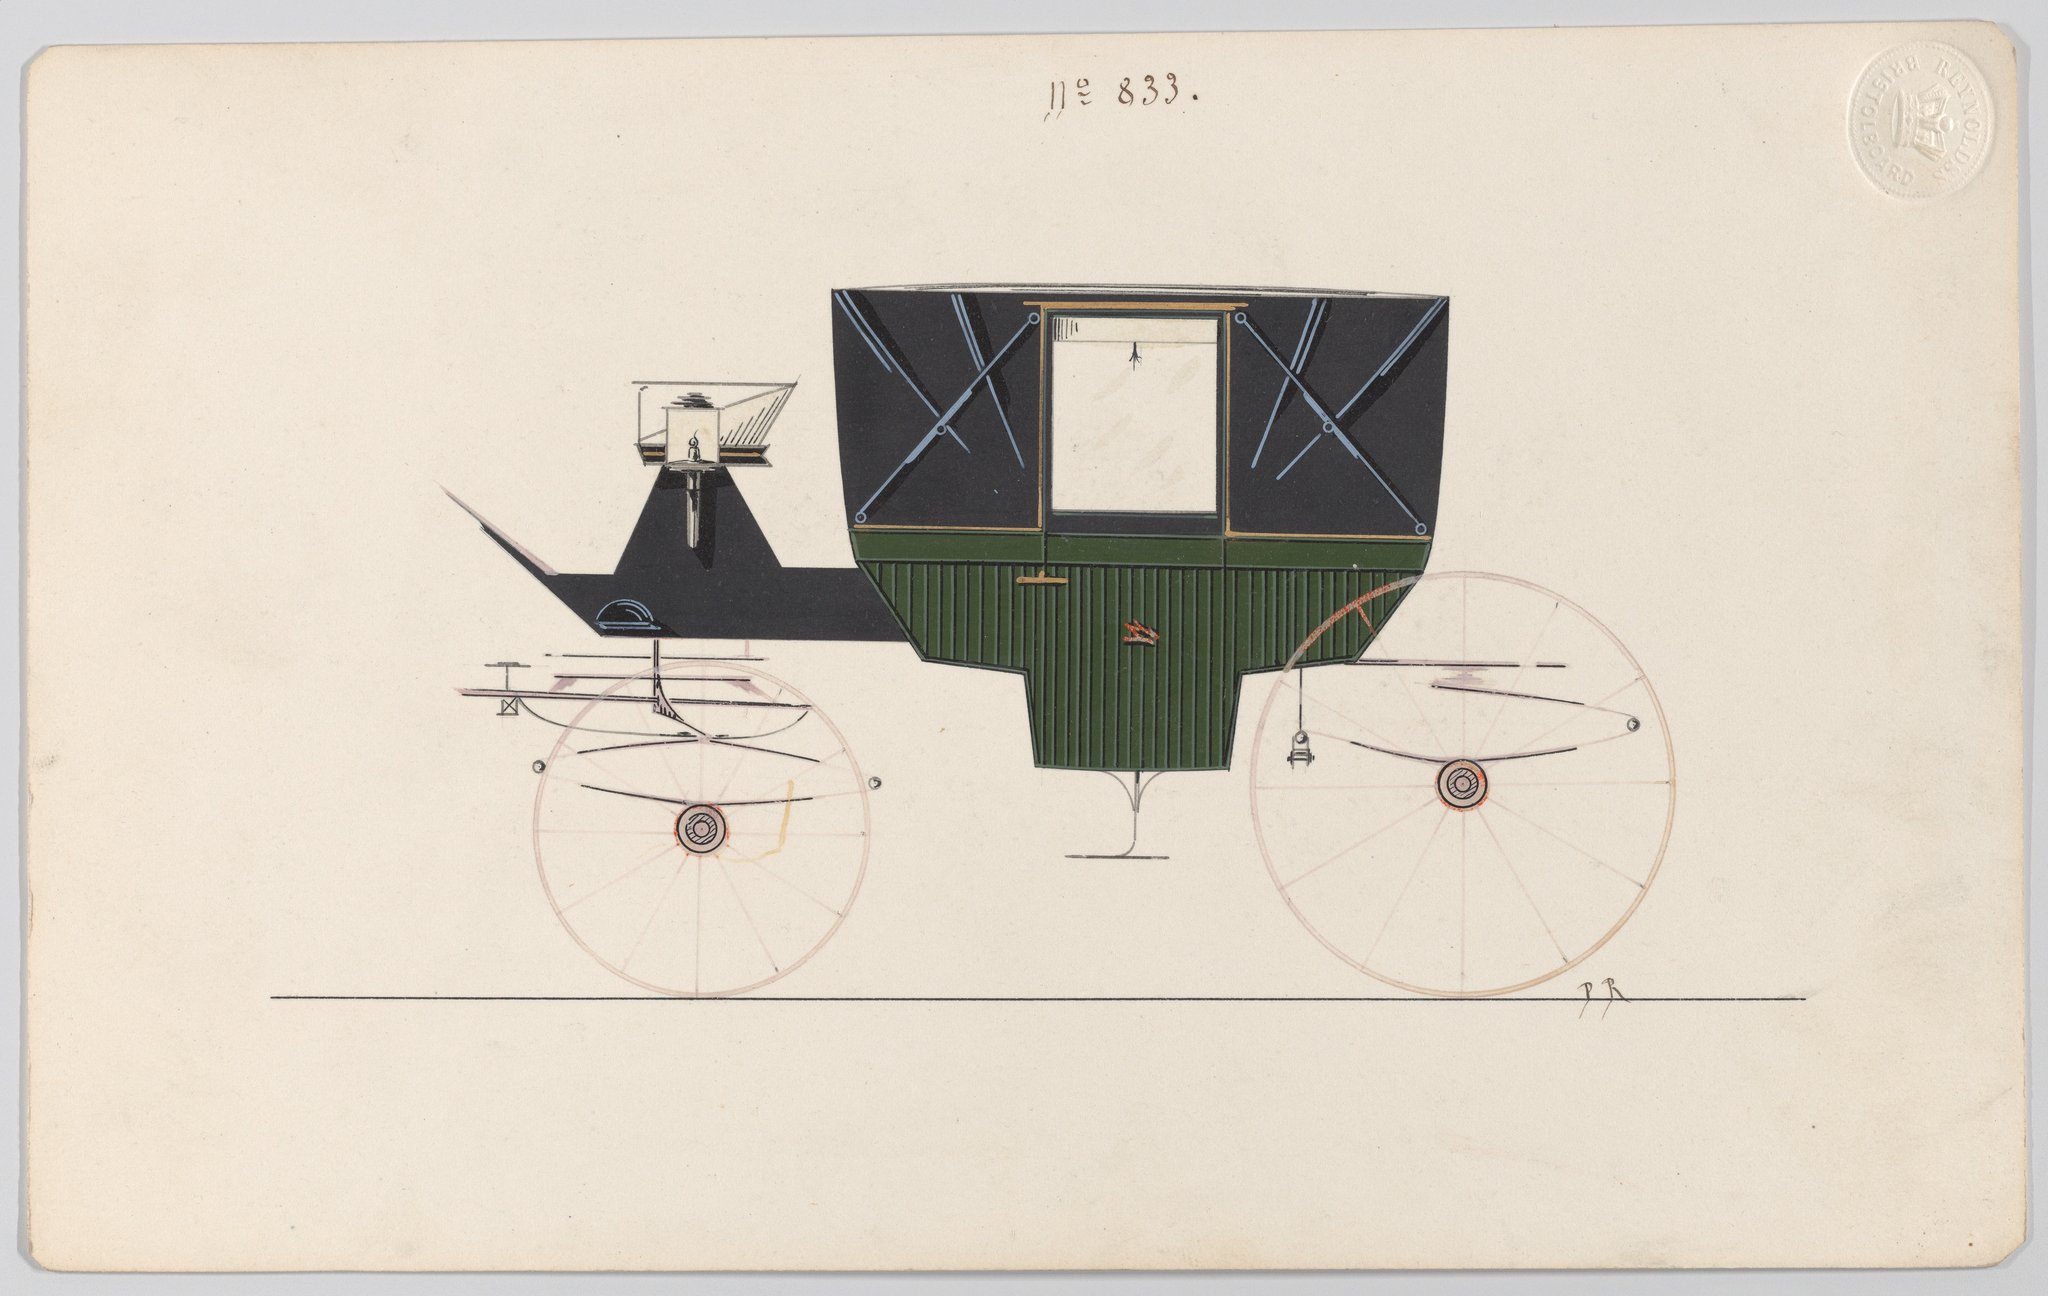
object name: drawing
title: Landau #833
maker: brewster & co.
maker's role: manufacturer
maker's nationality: american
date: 1850-1870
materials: gouache, gum arabic, ink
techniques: pen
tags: carriages